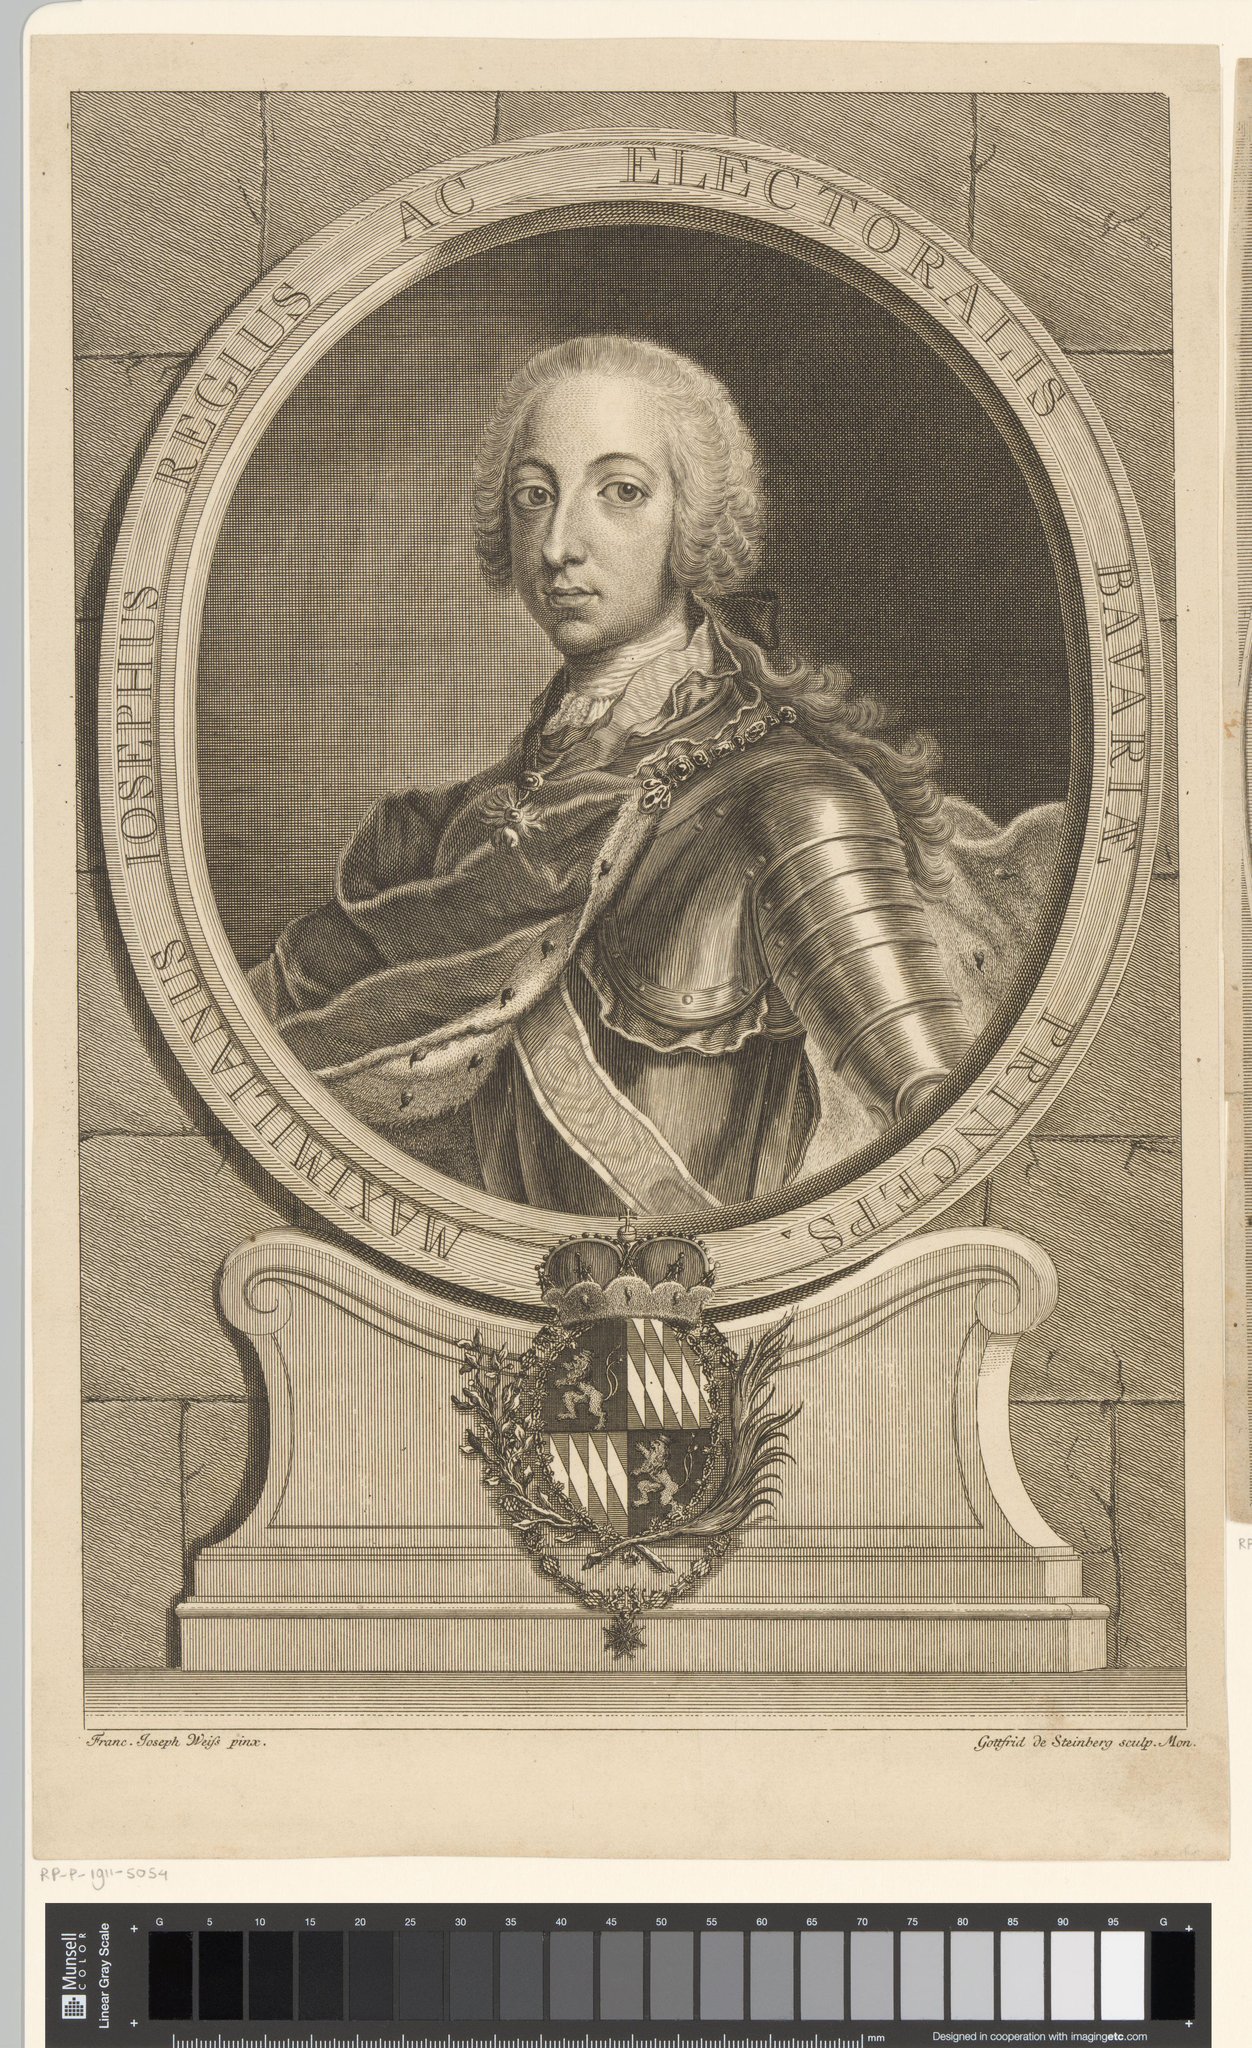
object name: print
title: Portret van Maximiliaan III Jozef van Beieren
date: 1745-1782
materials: paper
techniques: engraving, etching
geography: munich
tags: armour, historical persons, knighthood order of the golden fleece - insignia of a knighthood order, e.g.: badge, chain (with name of order), armorial bearing, heraldry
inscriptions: collector's mark: Lugt 2228